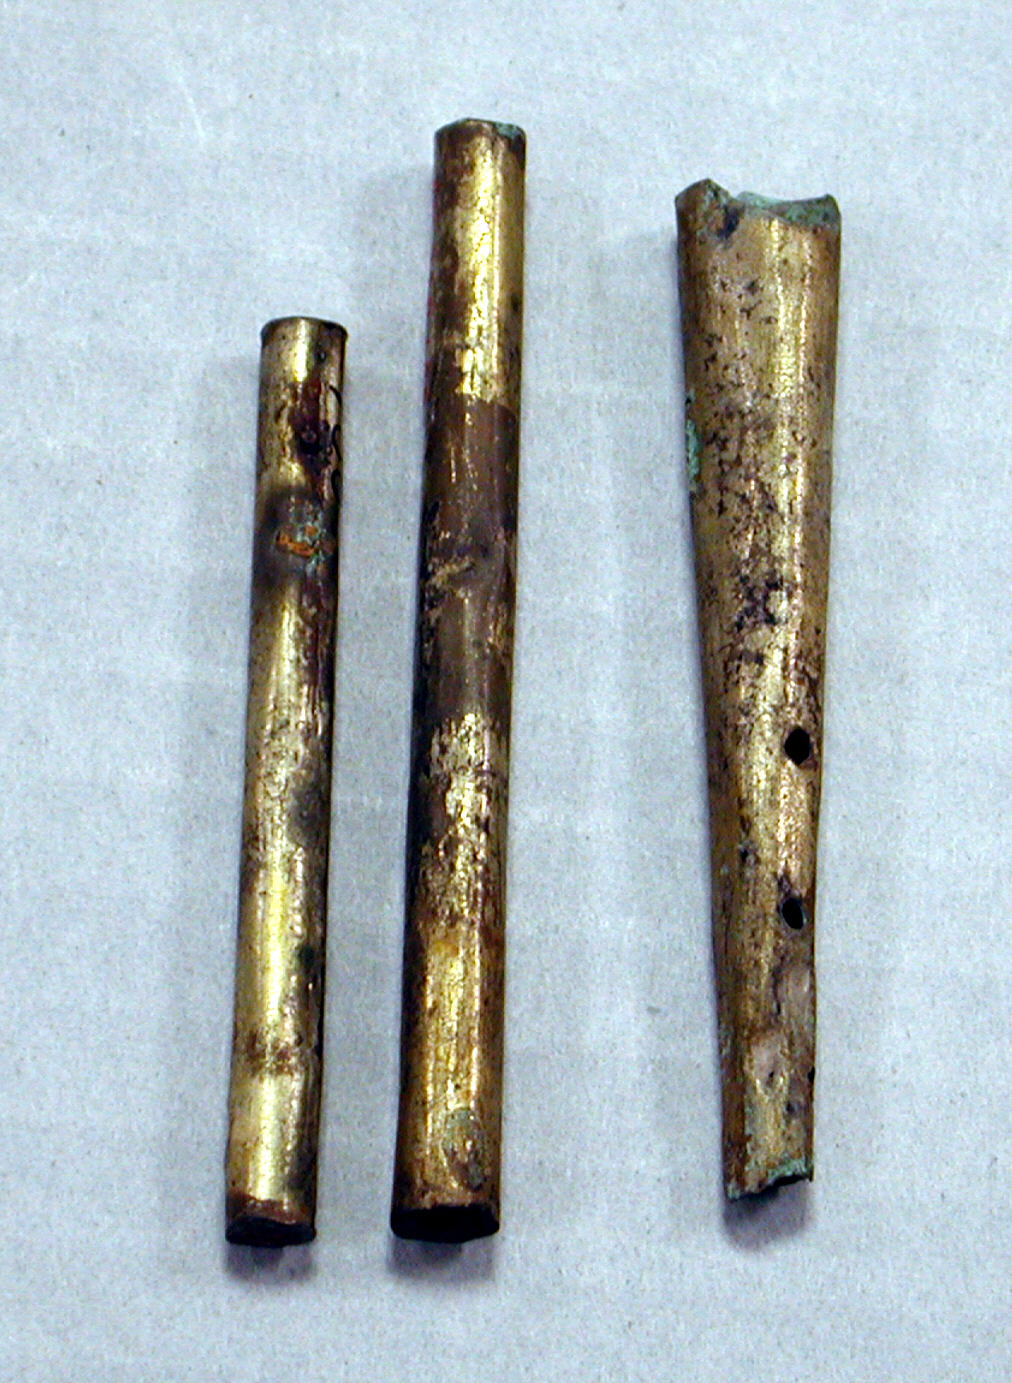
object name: ornament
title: Hammered Silver Tube Ornament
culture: peruvian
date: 701-1566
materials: gilt, silver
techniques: hammering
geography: peru